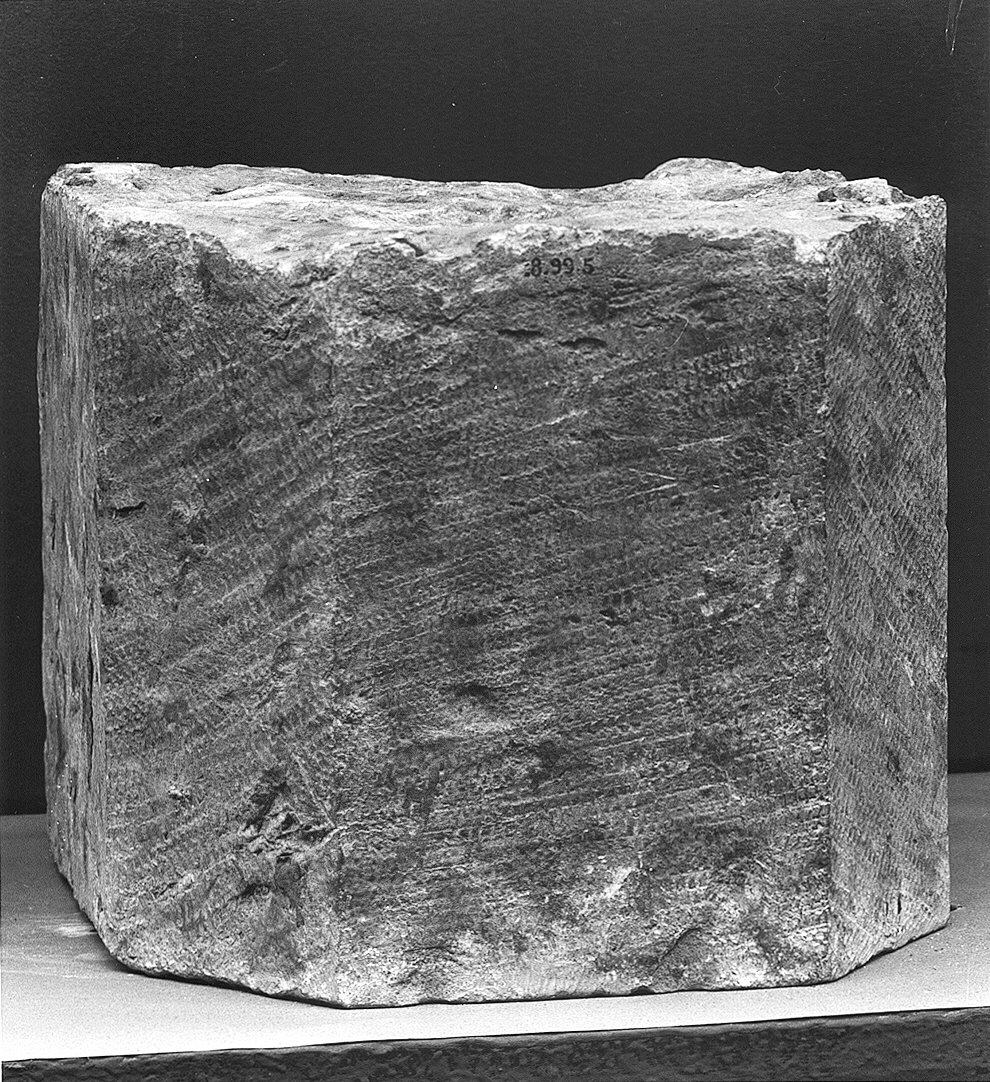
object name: rib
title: Part of a RIb of Groined Vaulting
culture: french or german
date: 1201-1300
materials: stone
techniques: polychromy